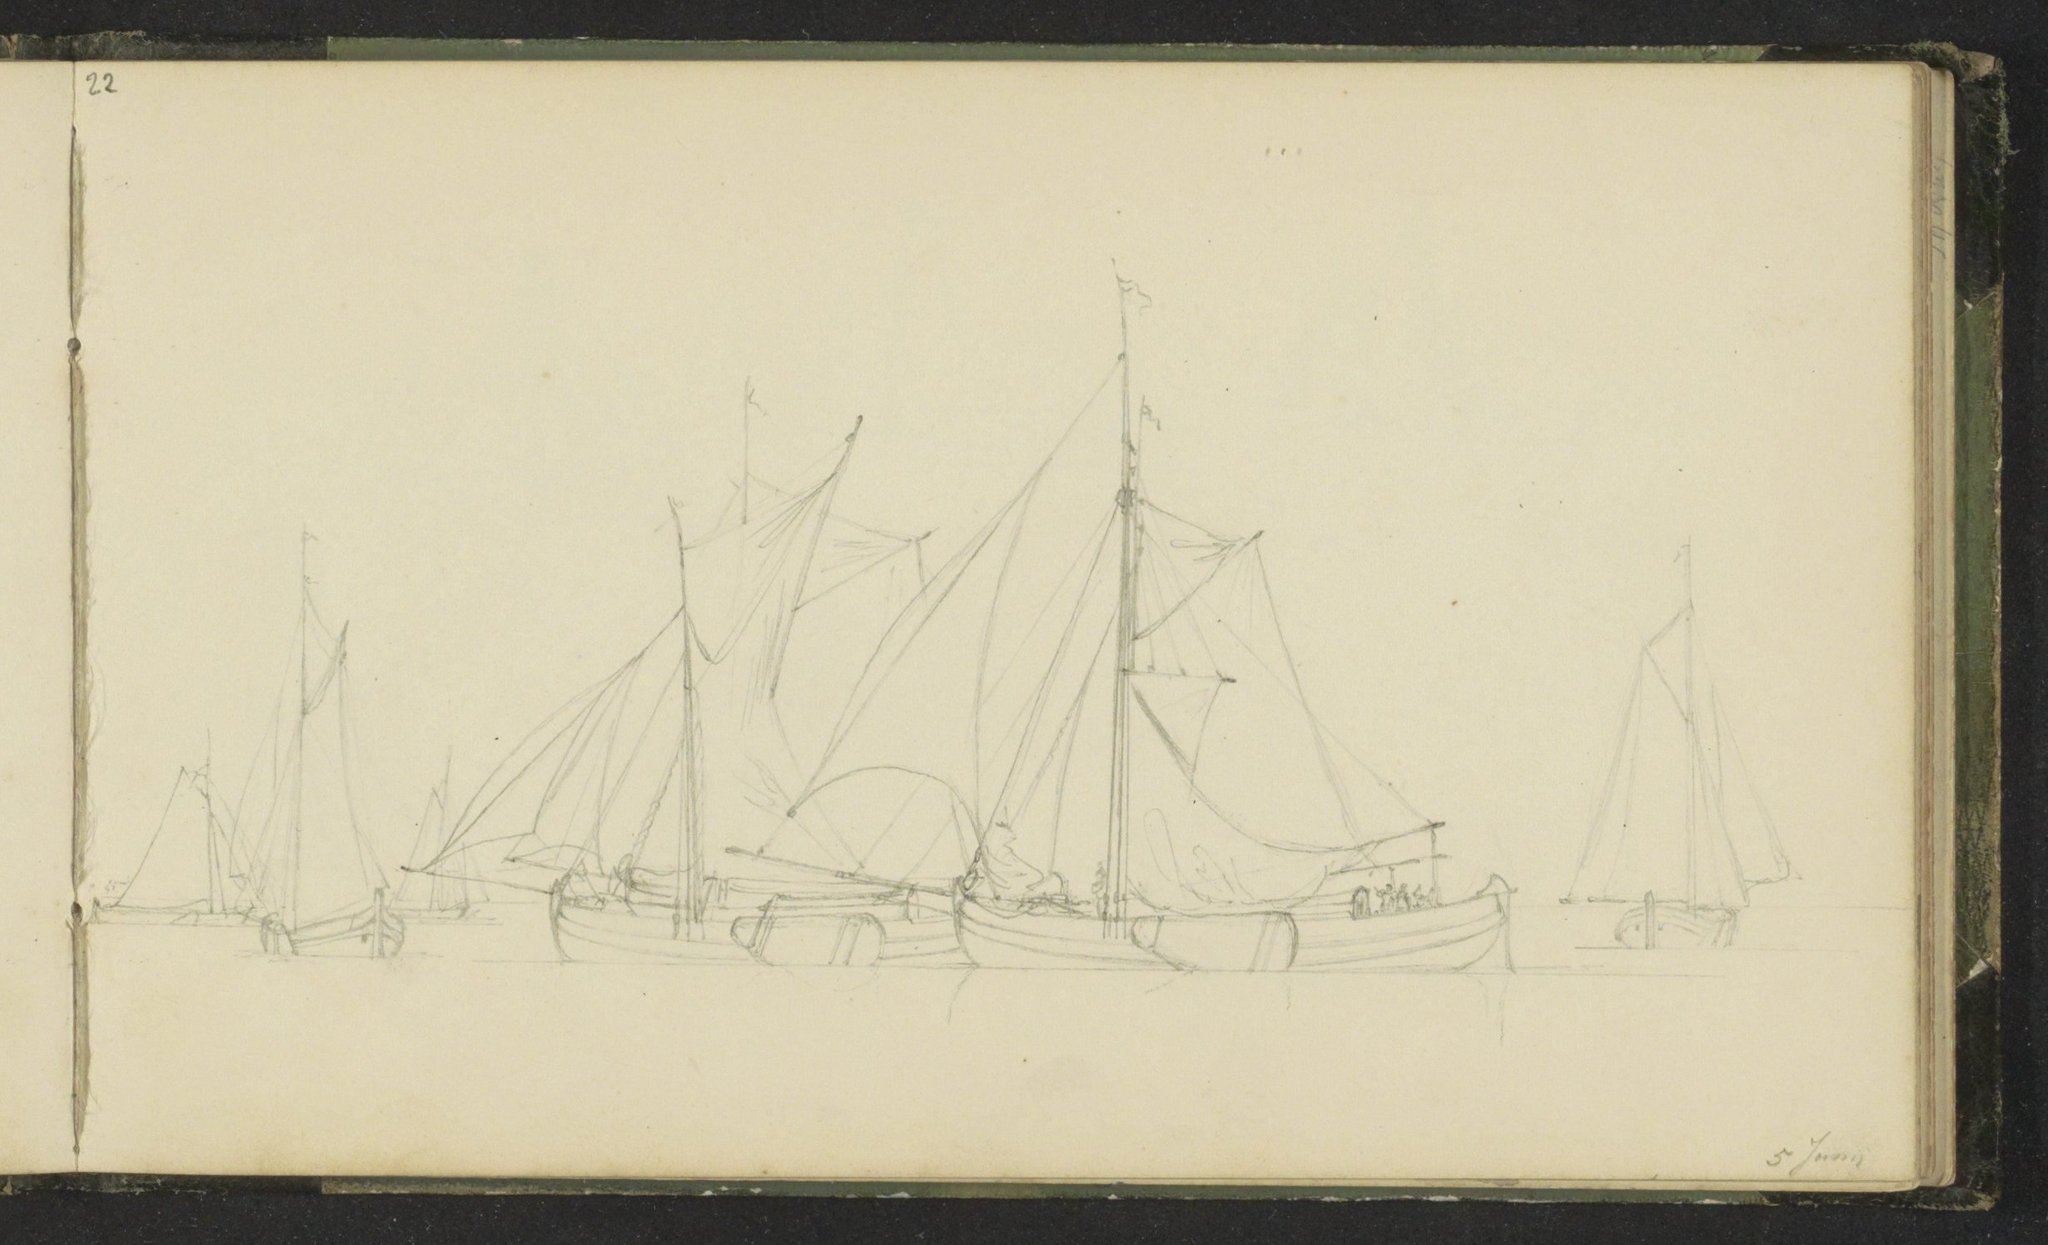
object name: sketchbook leaf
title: Afgemeerde zeilboten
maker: hendrik abraham klinkhamer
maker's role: draughtsman, painter, print maker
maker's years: 1810-1872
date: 1806-1843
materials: paper, pencil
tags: sailing-ship, sailing-boat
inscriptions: date: ‘5 Junij’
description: Blad 22 recto uit een schetsboek met 40 bladen.